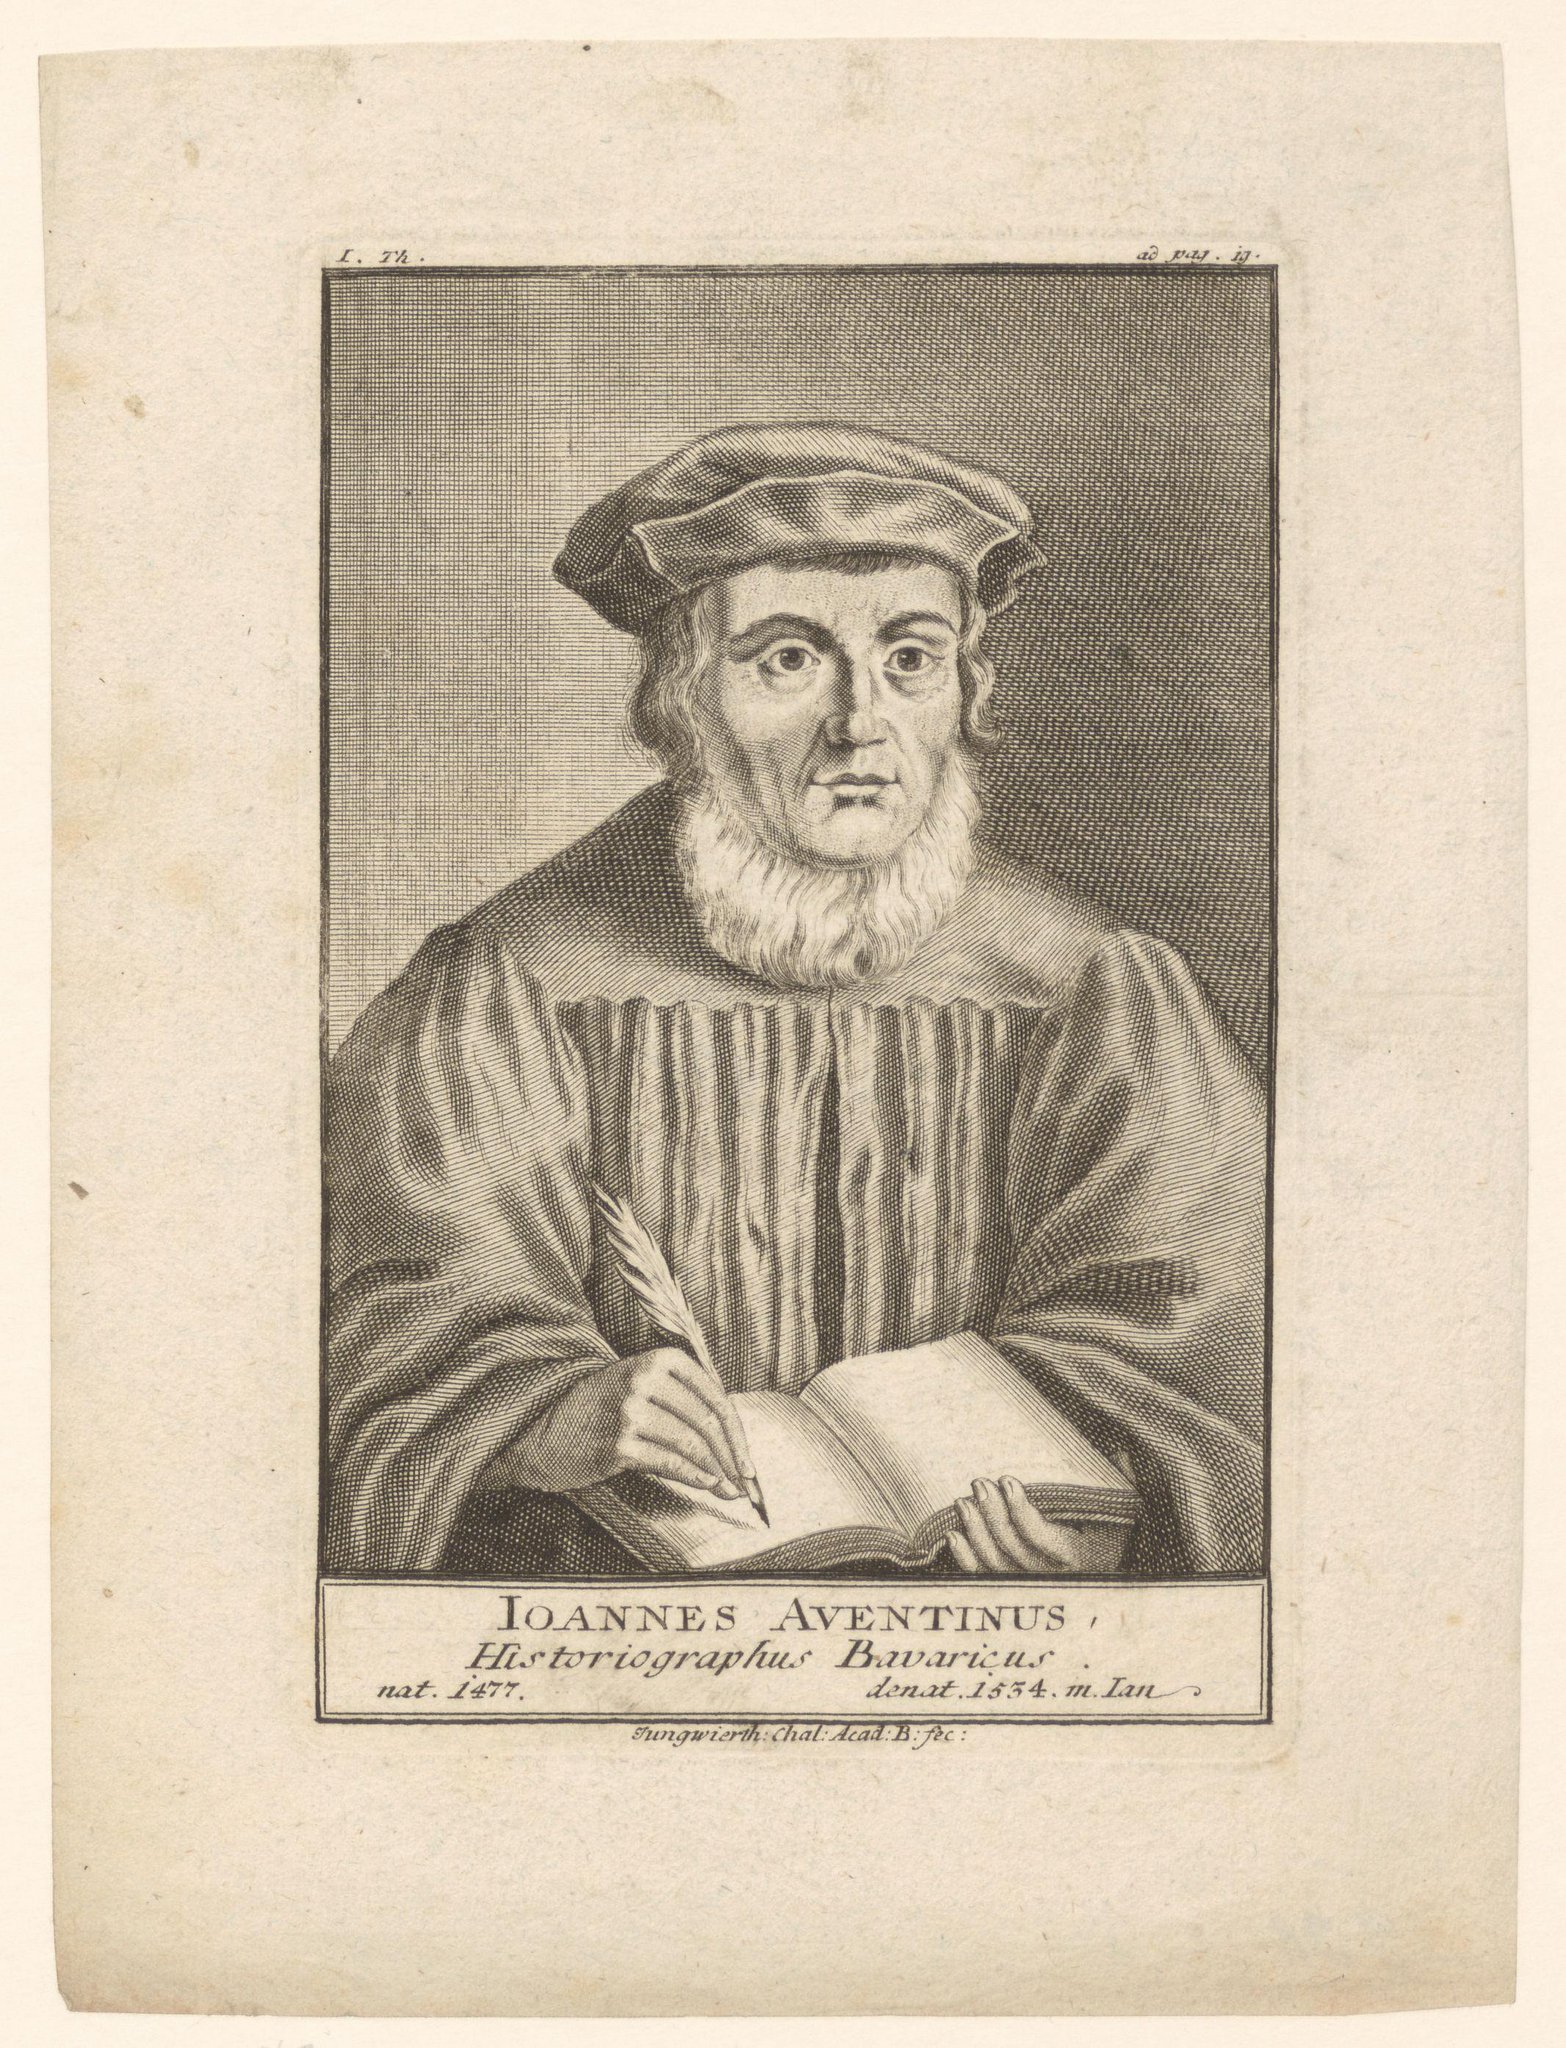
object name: print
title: Portret van Johannes Aventinus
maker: franz xaver jungwirth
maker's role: print maker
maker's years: 1720-1790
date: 1730-1790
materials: paper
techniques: engraving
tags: historical persons, portrait of a writer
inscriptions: collector's mark: Lugt 2228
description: Deze prent hoort bij een onbekende serie te identificeren aan de hand van tekst bovenaan: I. Th. en ad. pag. 19.